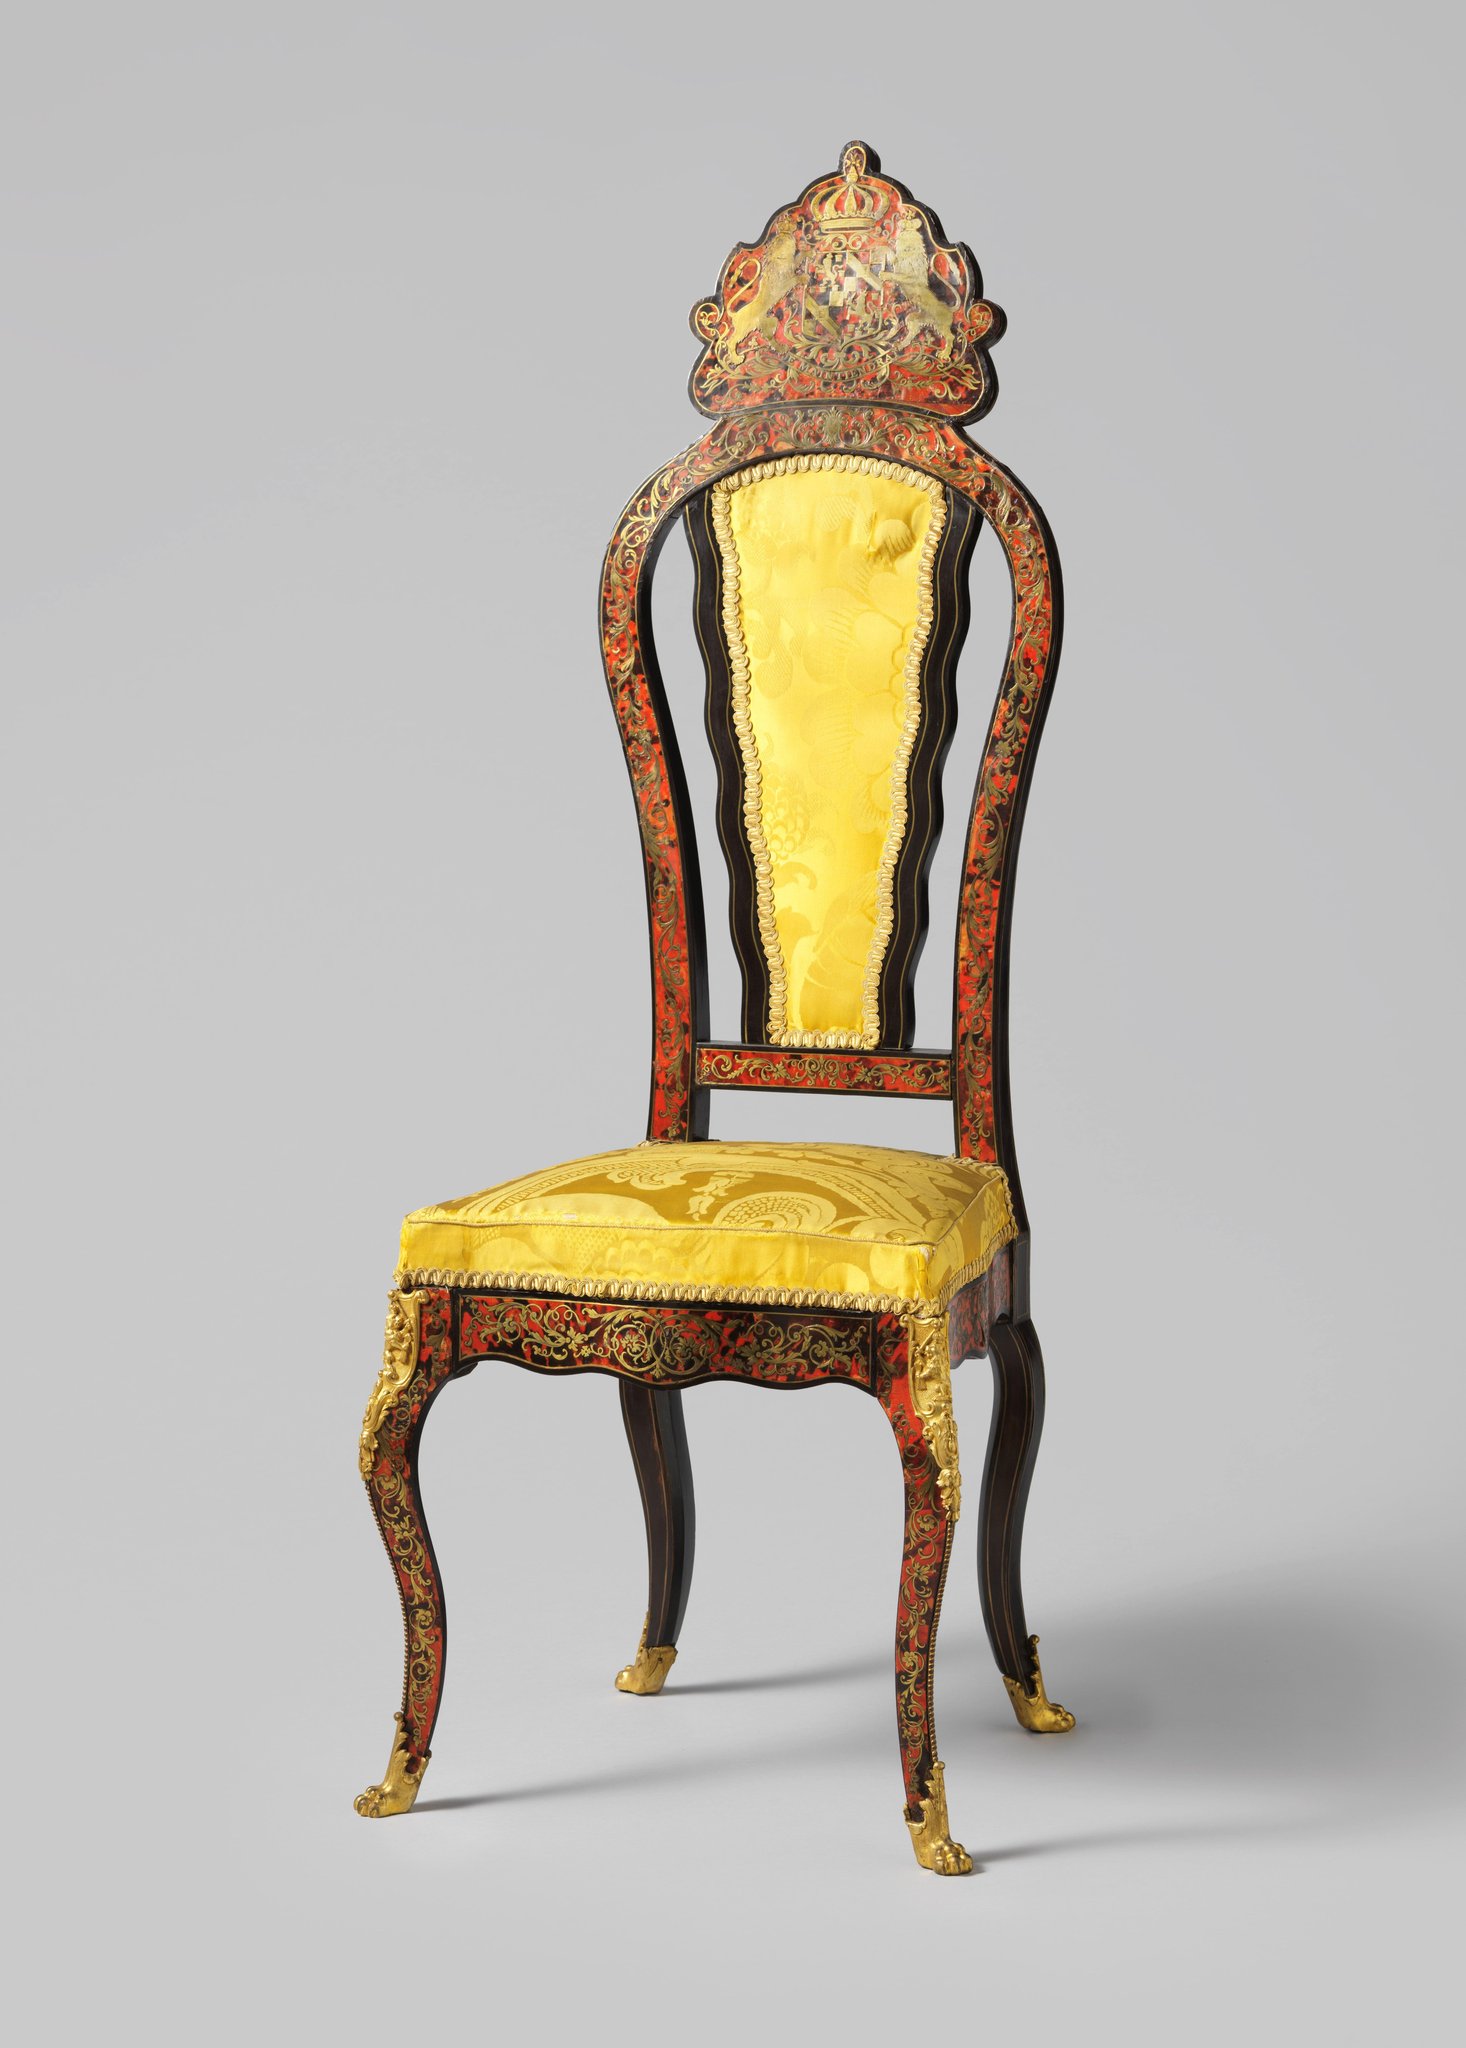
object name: chair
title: Stoel, neo-Boulle met Nederlands wapen op de kap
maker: Anonymous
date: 1850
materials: brass, wood, shell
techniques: damask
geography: france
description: Chair. Softwood, veneered with marquetry of brass and tortoiseshell on a red ground. Paris, c. 1839, by Eugène-Paul Caillaux. The chair forms part of a set of furniture bought by King William II when Prince of Orange from the Hague dealer C.I. Enthoven. The arms of the Netherlands are mounted on the back. On loan from H.R.H. Princess Juliana of the Netherlands.